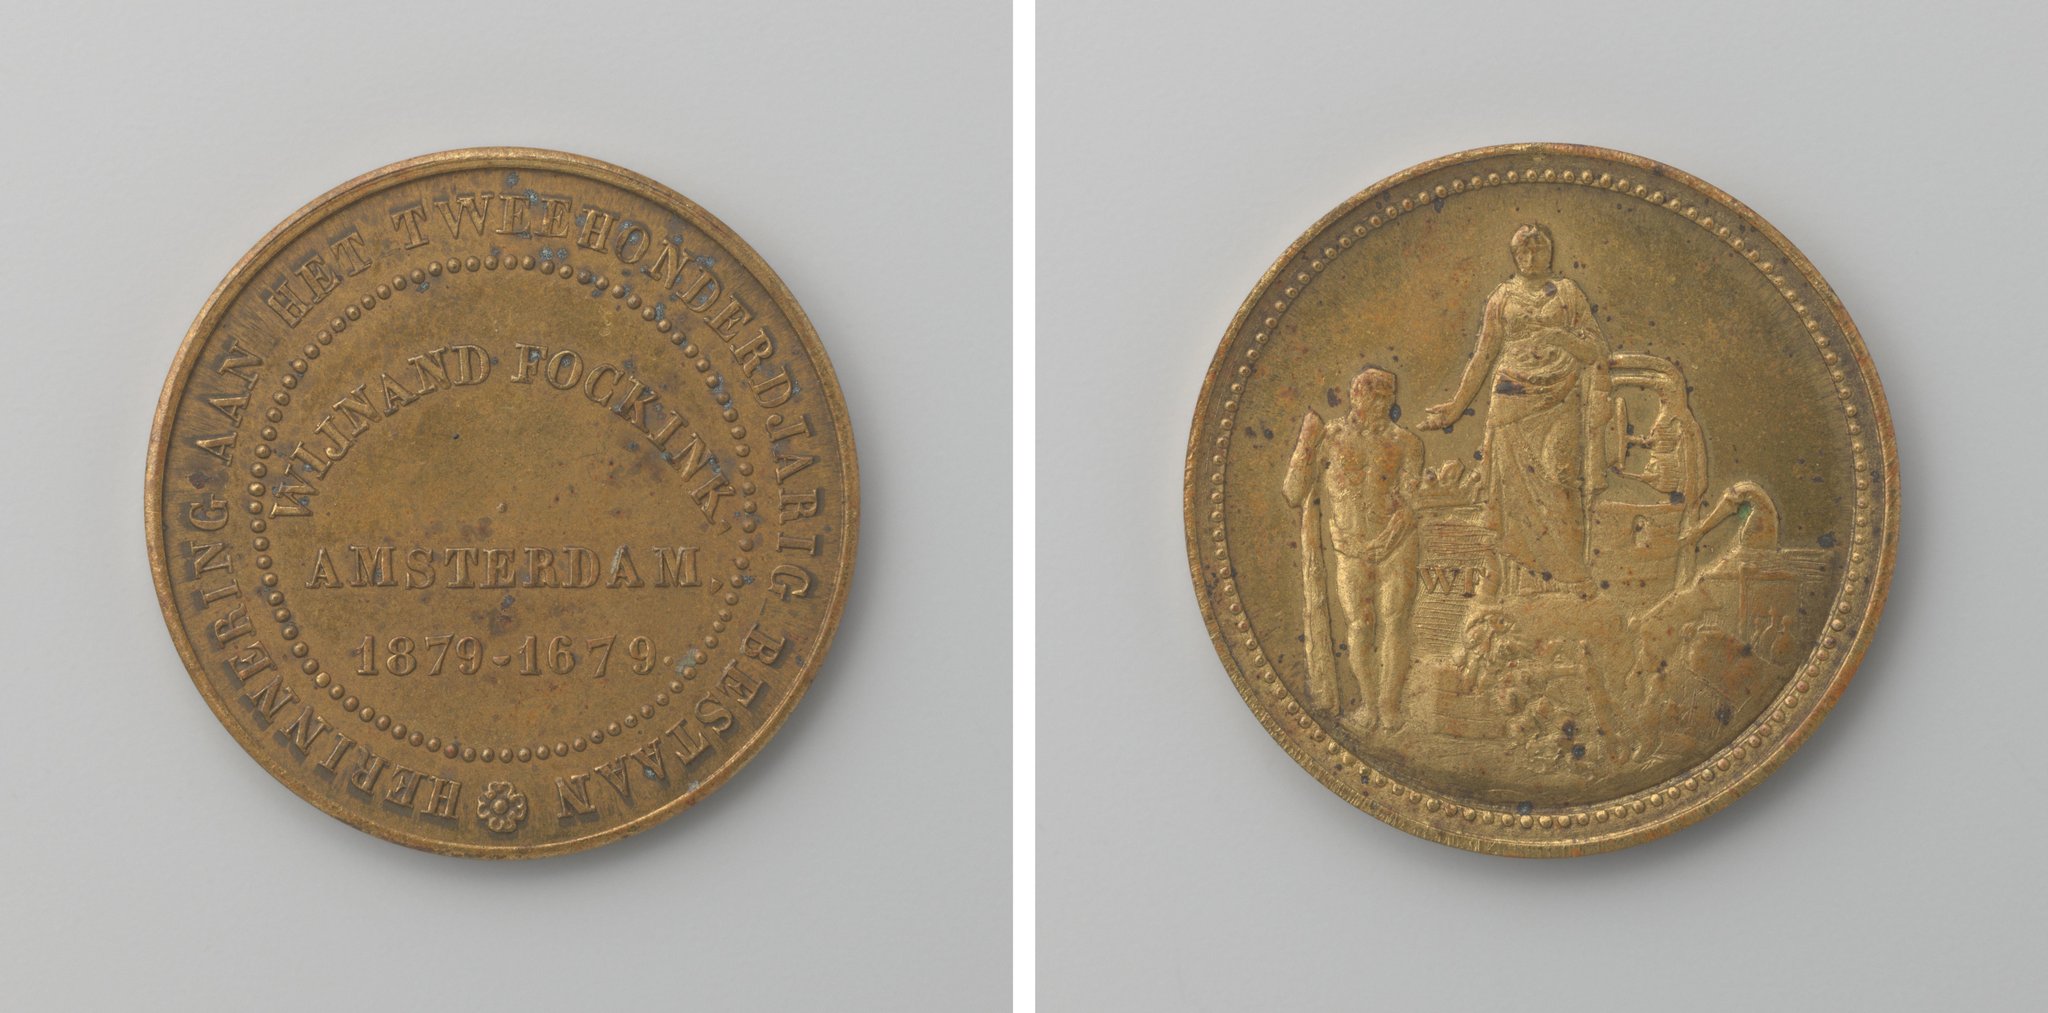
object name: history medal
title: Tweehonderdjarig bestaan van de likeurstokerij van Wijnand Focking te Amsterdam 1879, reclamepenning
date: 1879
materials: brass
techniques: striking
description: Messing penning, op de voorzijde een vrouw staand op een wereldbol waartegen een hoorn des overvloeds, links een wildeman met knots en een gekroond schild met WF, en rechts en onder attributen voor de drankbereiding, op de keerzijde drie regels tekst met omschrift.